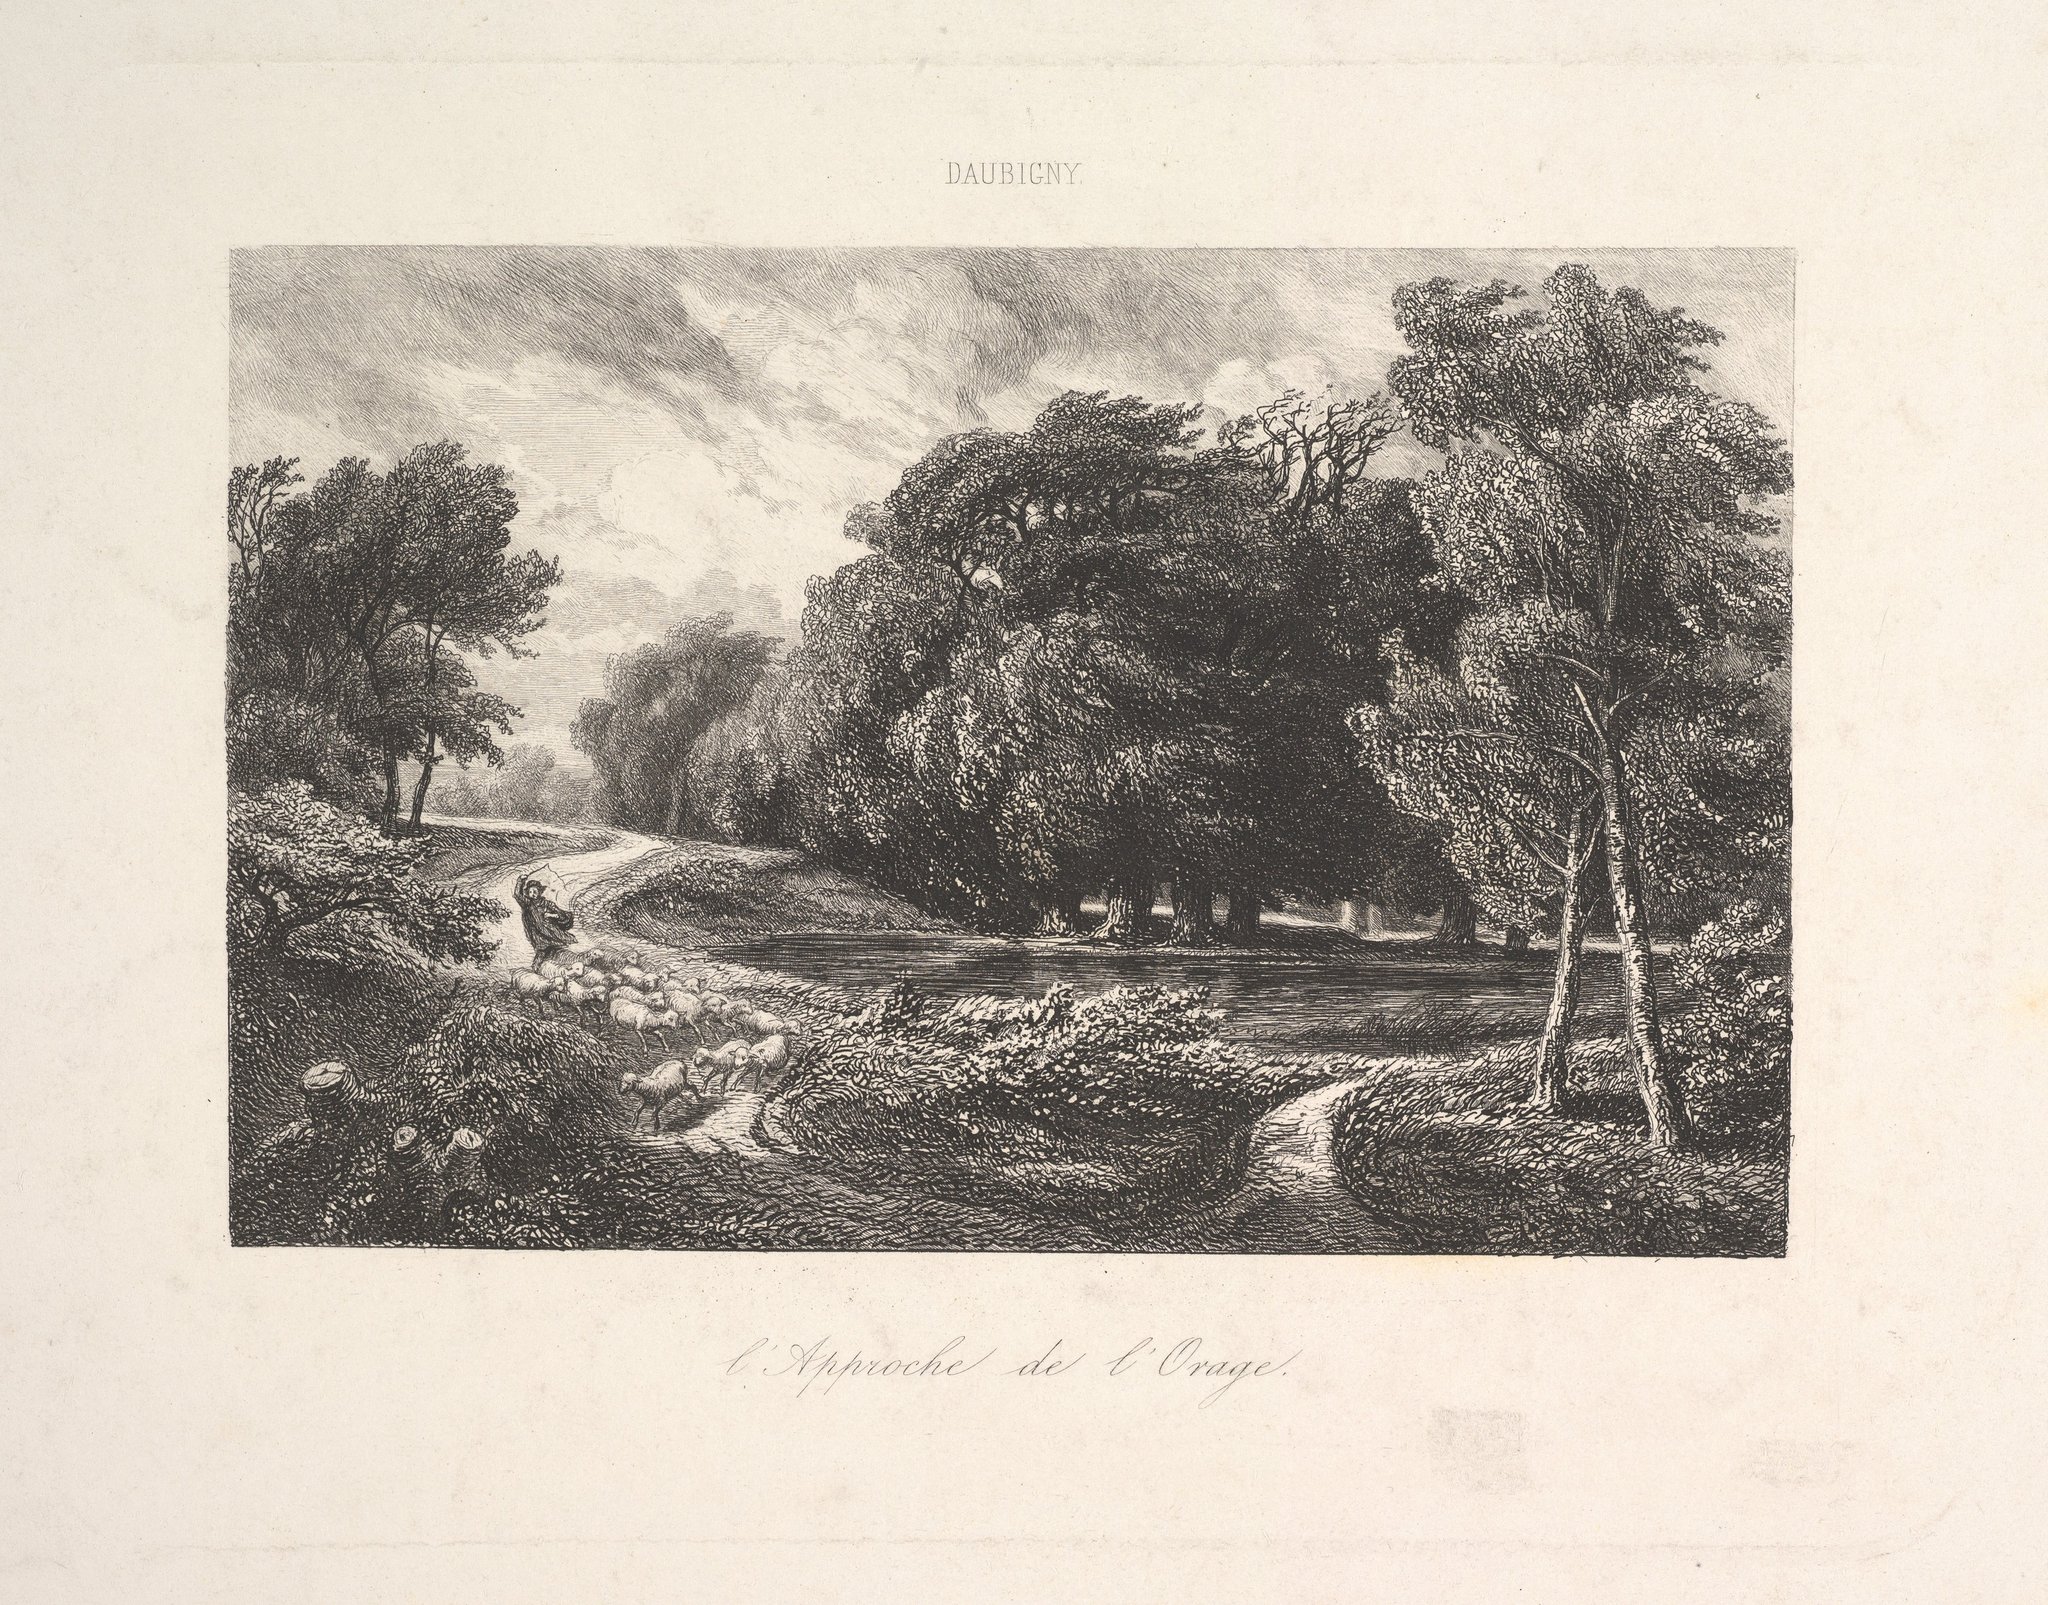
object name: print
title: The Approaching Storm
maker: charles-françois daubigny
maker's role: artist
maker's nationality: french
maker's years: 1817-1878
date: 1844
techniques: etching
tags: animals,trees,storms